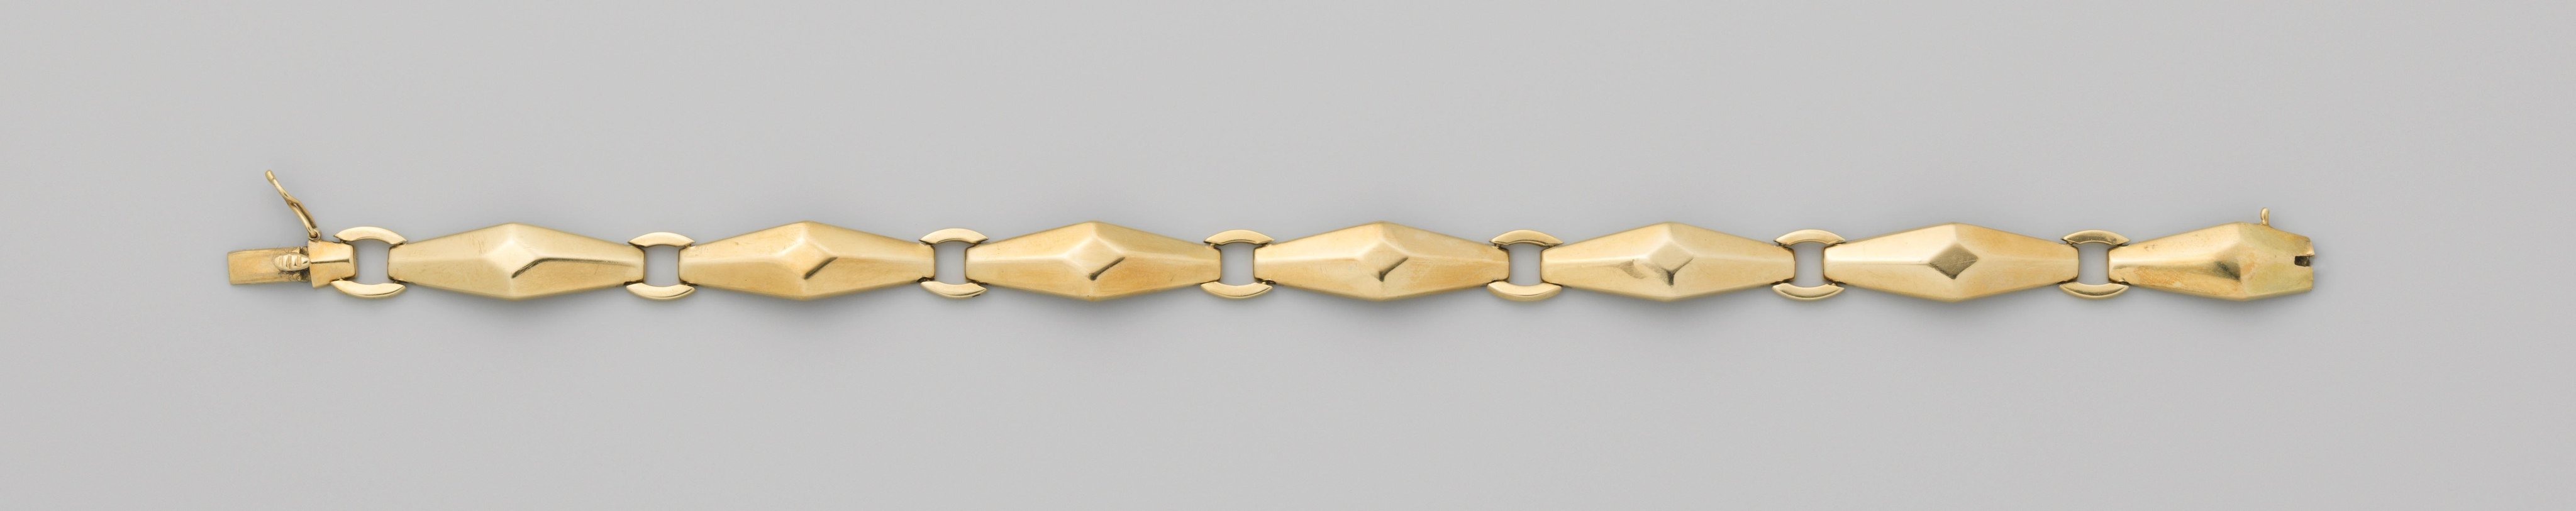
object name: chain bracelet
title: Schakelarmband van goud met ruitvormige schakel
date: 1935-1940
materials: gold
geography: amsterdam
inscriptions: maker's mark: ‘HDZ.’, alloy mark: ‘(oud) eikenblad’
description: Armband van goud met ruitvormige schakel, die rechthoekig is opgewerkt. Voorzien van een baksluiting met een veiligheidsachtje.